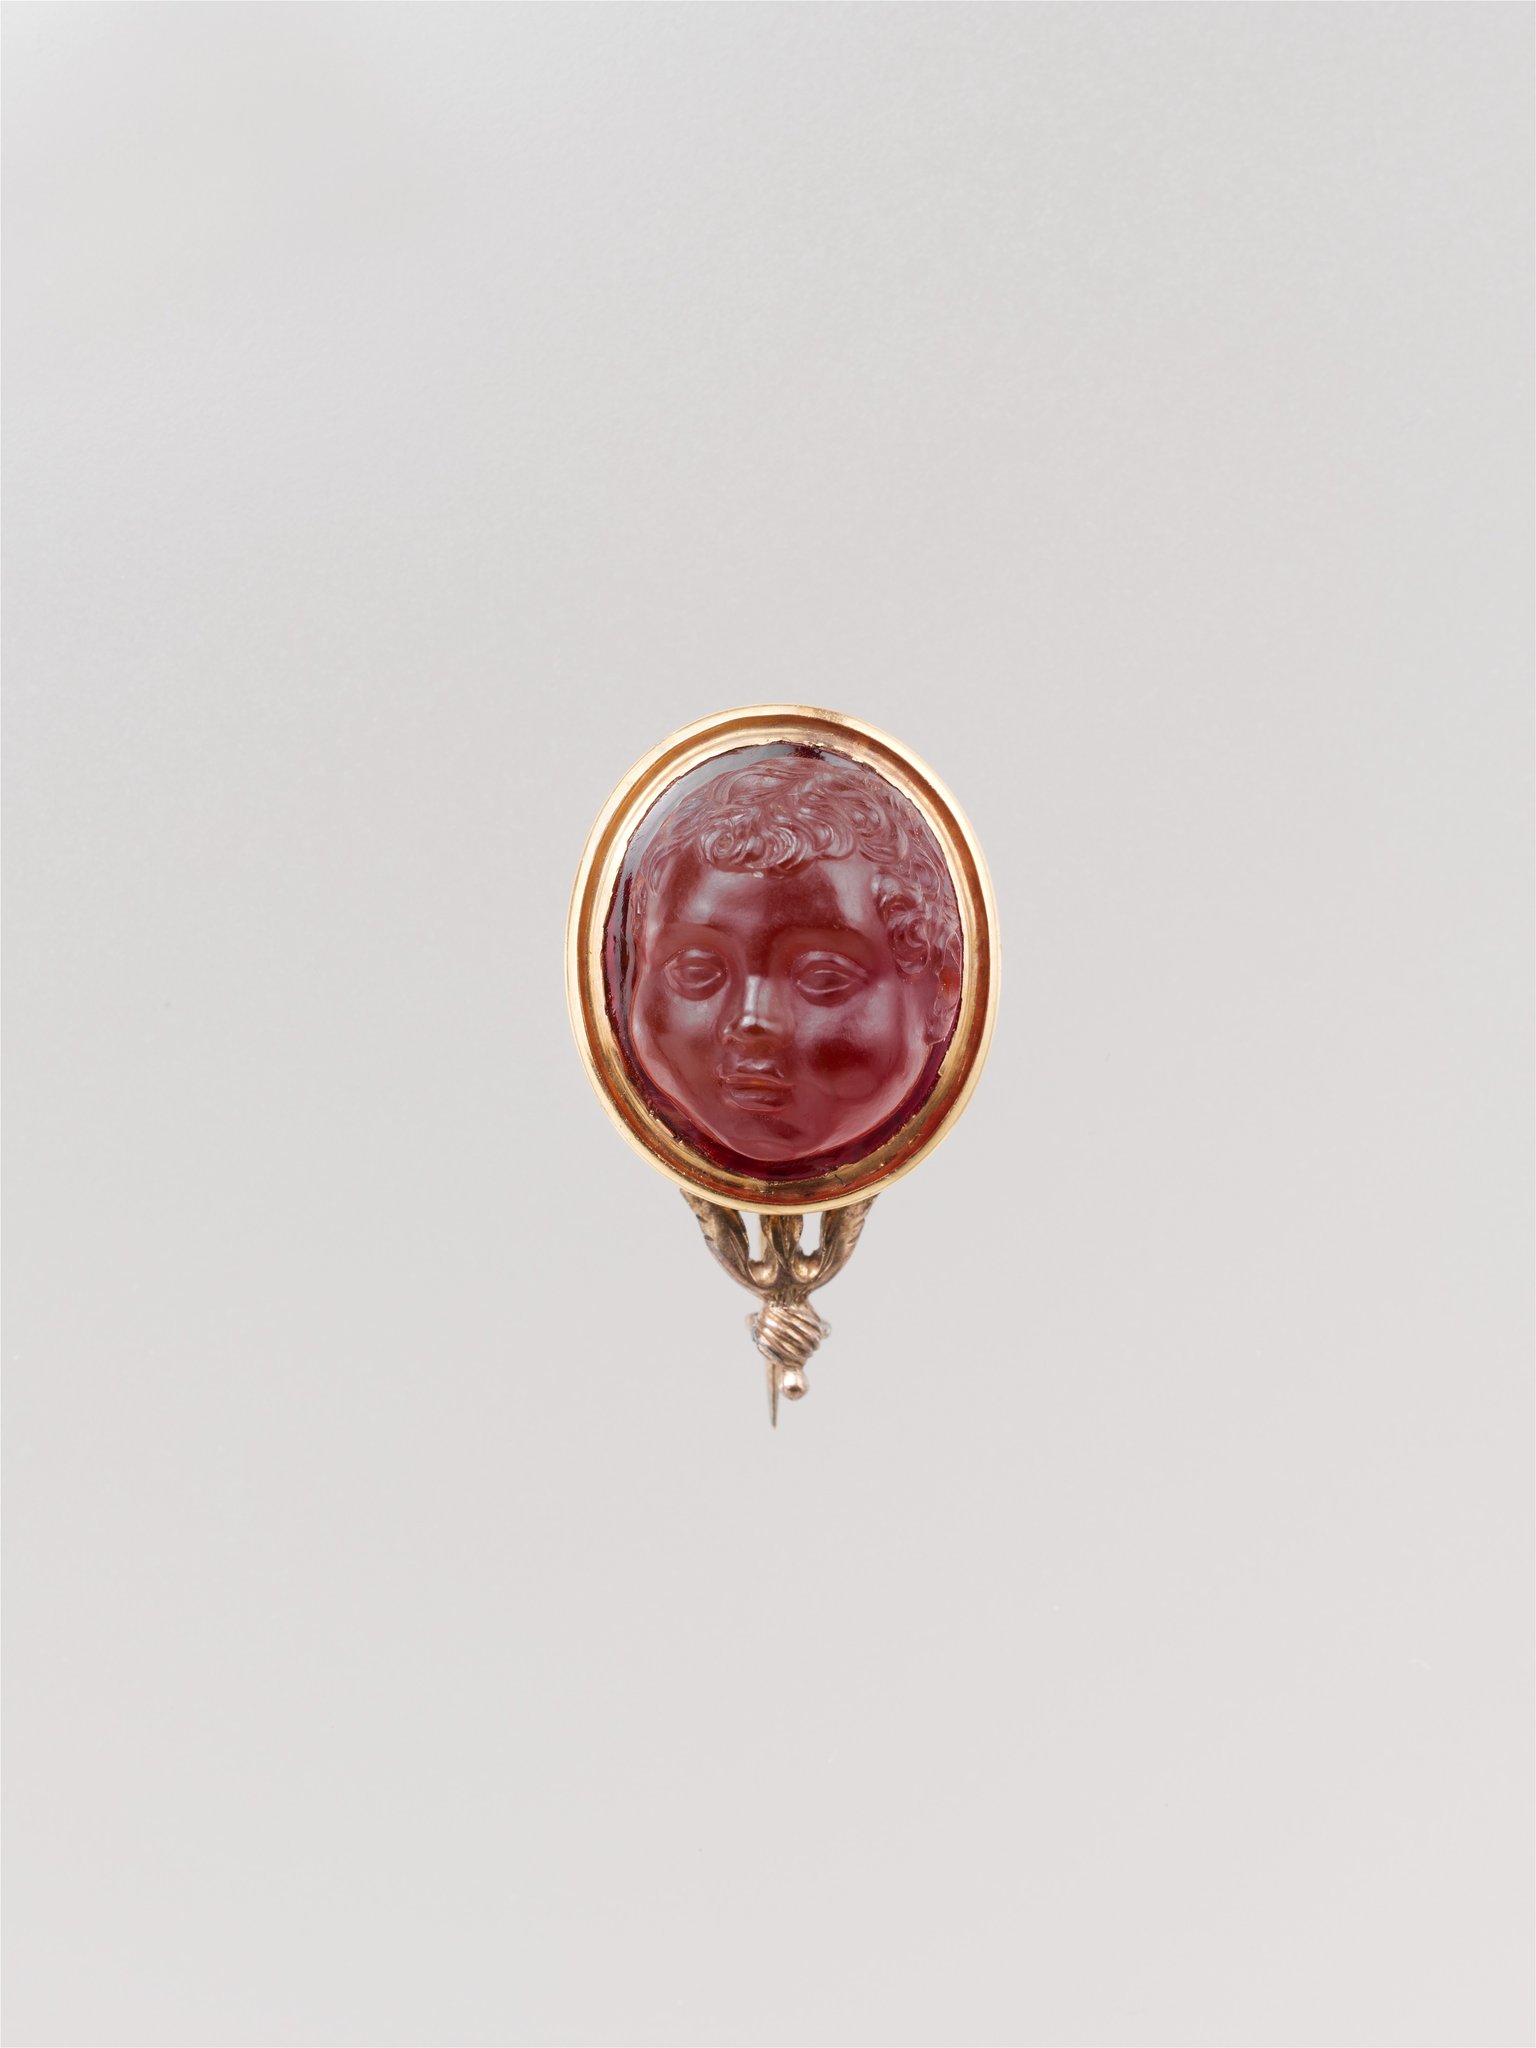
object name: cameo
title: Head of a little boy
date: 1501-1550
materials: gemstone, gold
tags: heads,boys